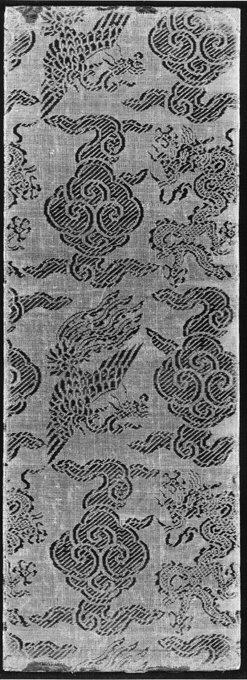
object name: sutra cover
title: Sutra cover with dragons and phoenixes amid clouds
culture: chinese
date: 1501-1600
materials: silk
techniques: patterning, weave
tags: mythical creatures,dragons